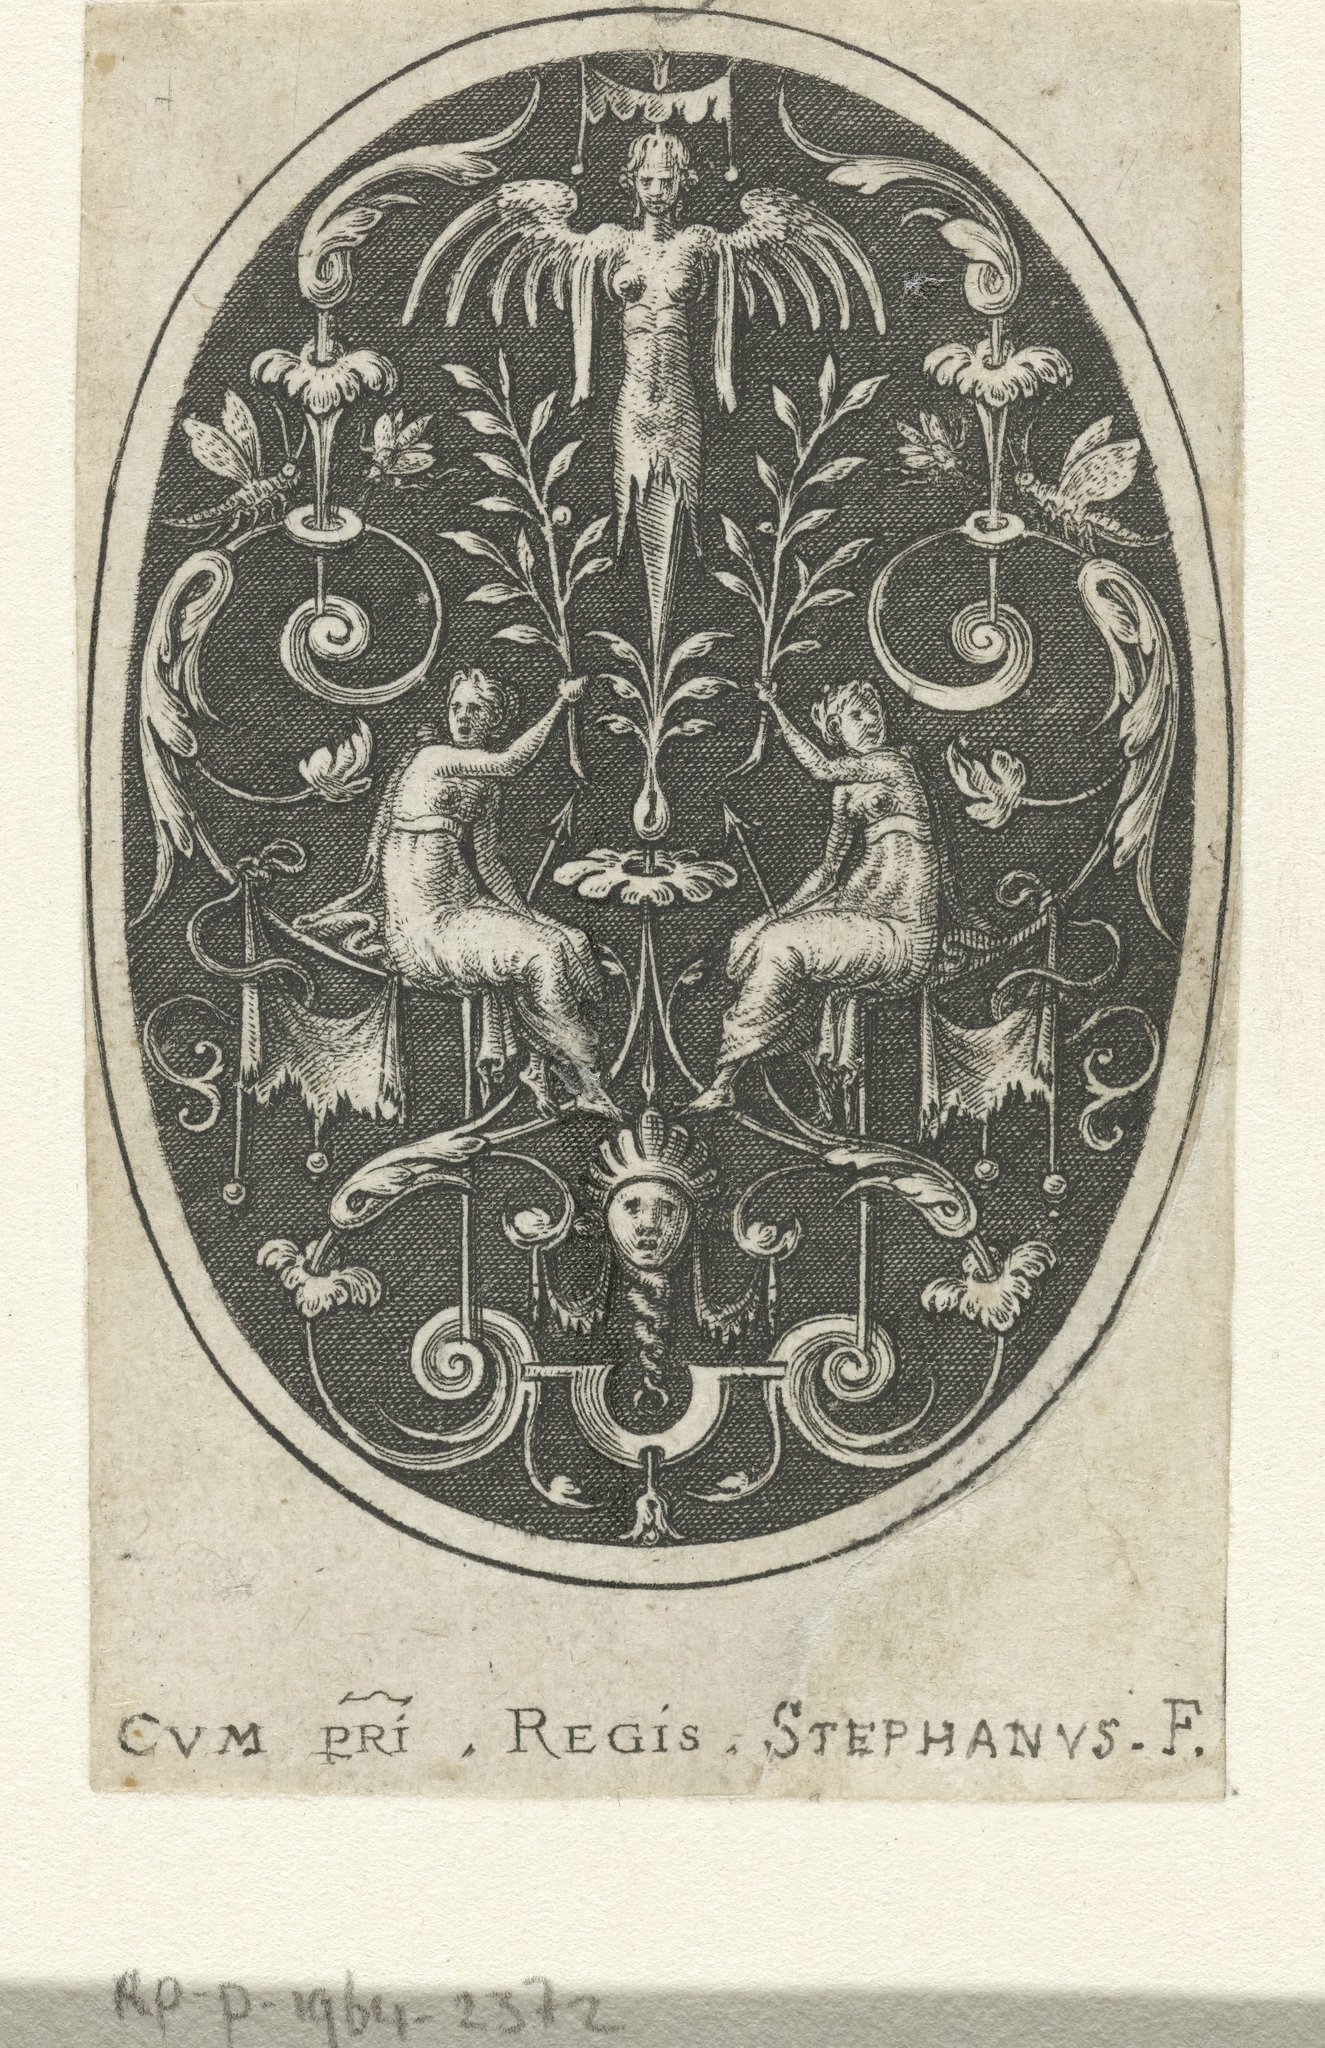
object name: ornament print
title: Ornament met twee zittende vrouwen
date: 1528-1583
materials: paper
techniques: engraving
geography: france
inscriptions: inscription: ‘STEPHANVS.F’